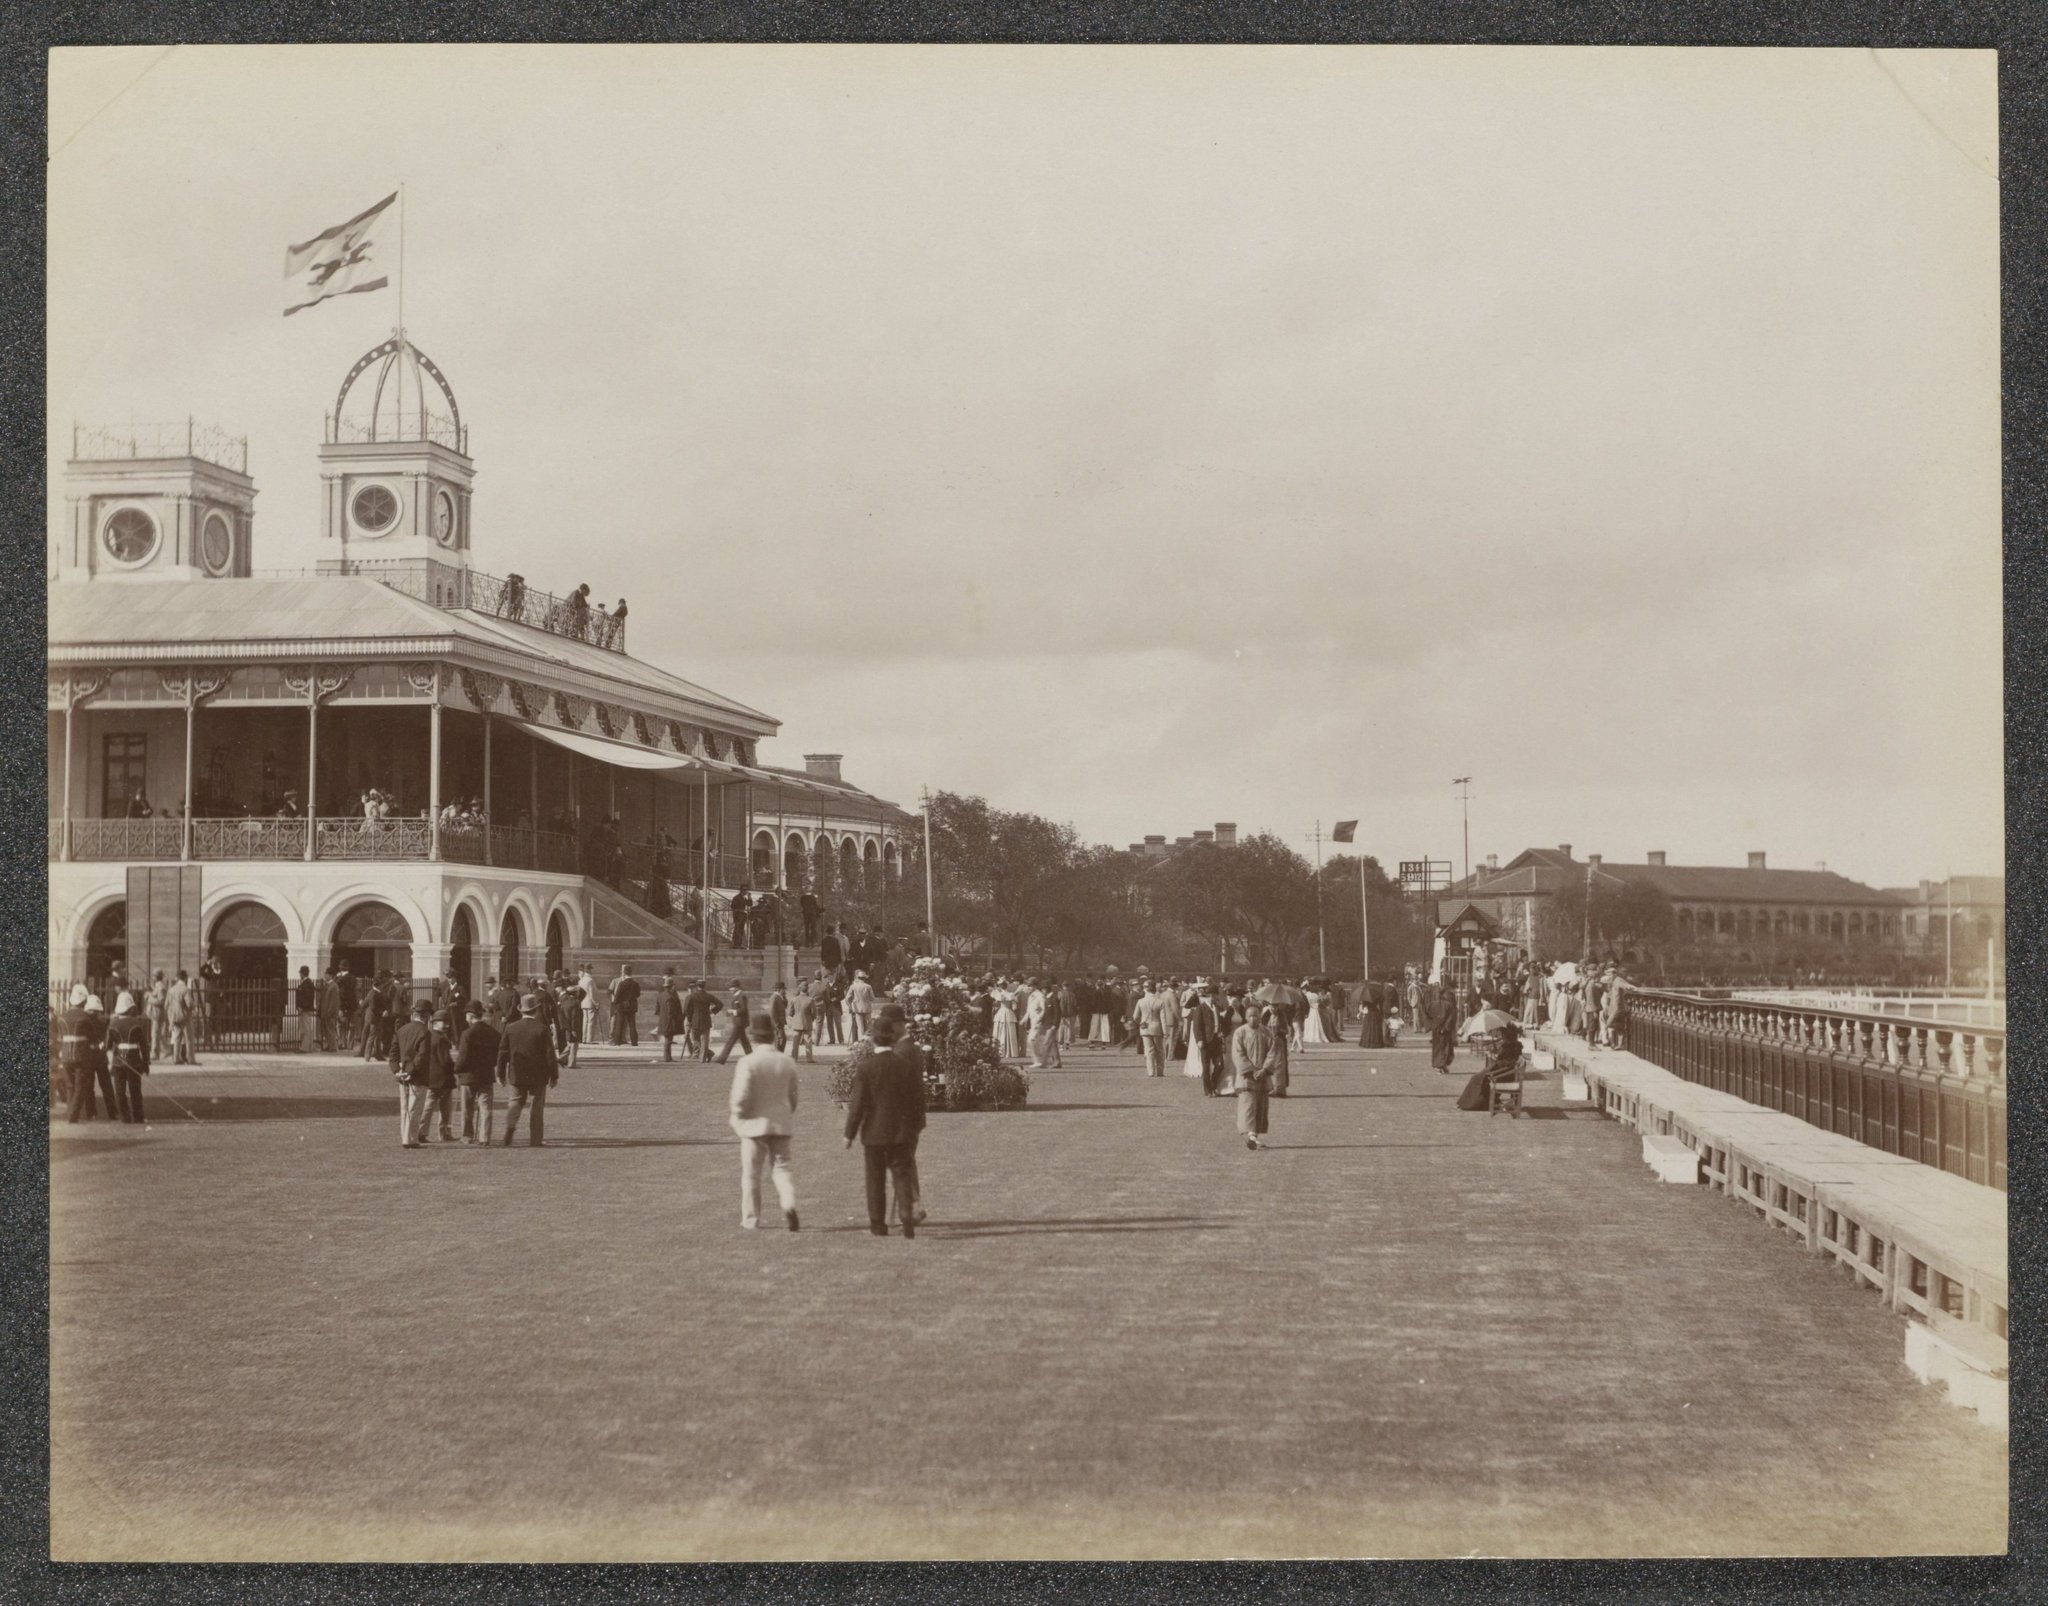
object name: photograph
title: Gezicht op de paardenrenbaan en tribune van Shanghai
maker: Anonymous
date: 1890-1900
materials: paper, photographic support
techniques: albumen print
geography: shanghai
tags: horse-racing, race-track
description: Onderdeel van Album met 50 foto's van een reis door Zuidoost-Azië.